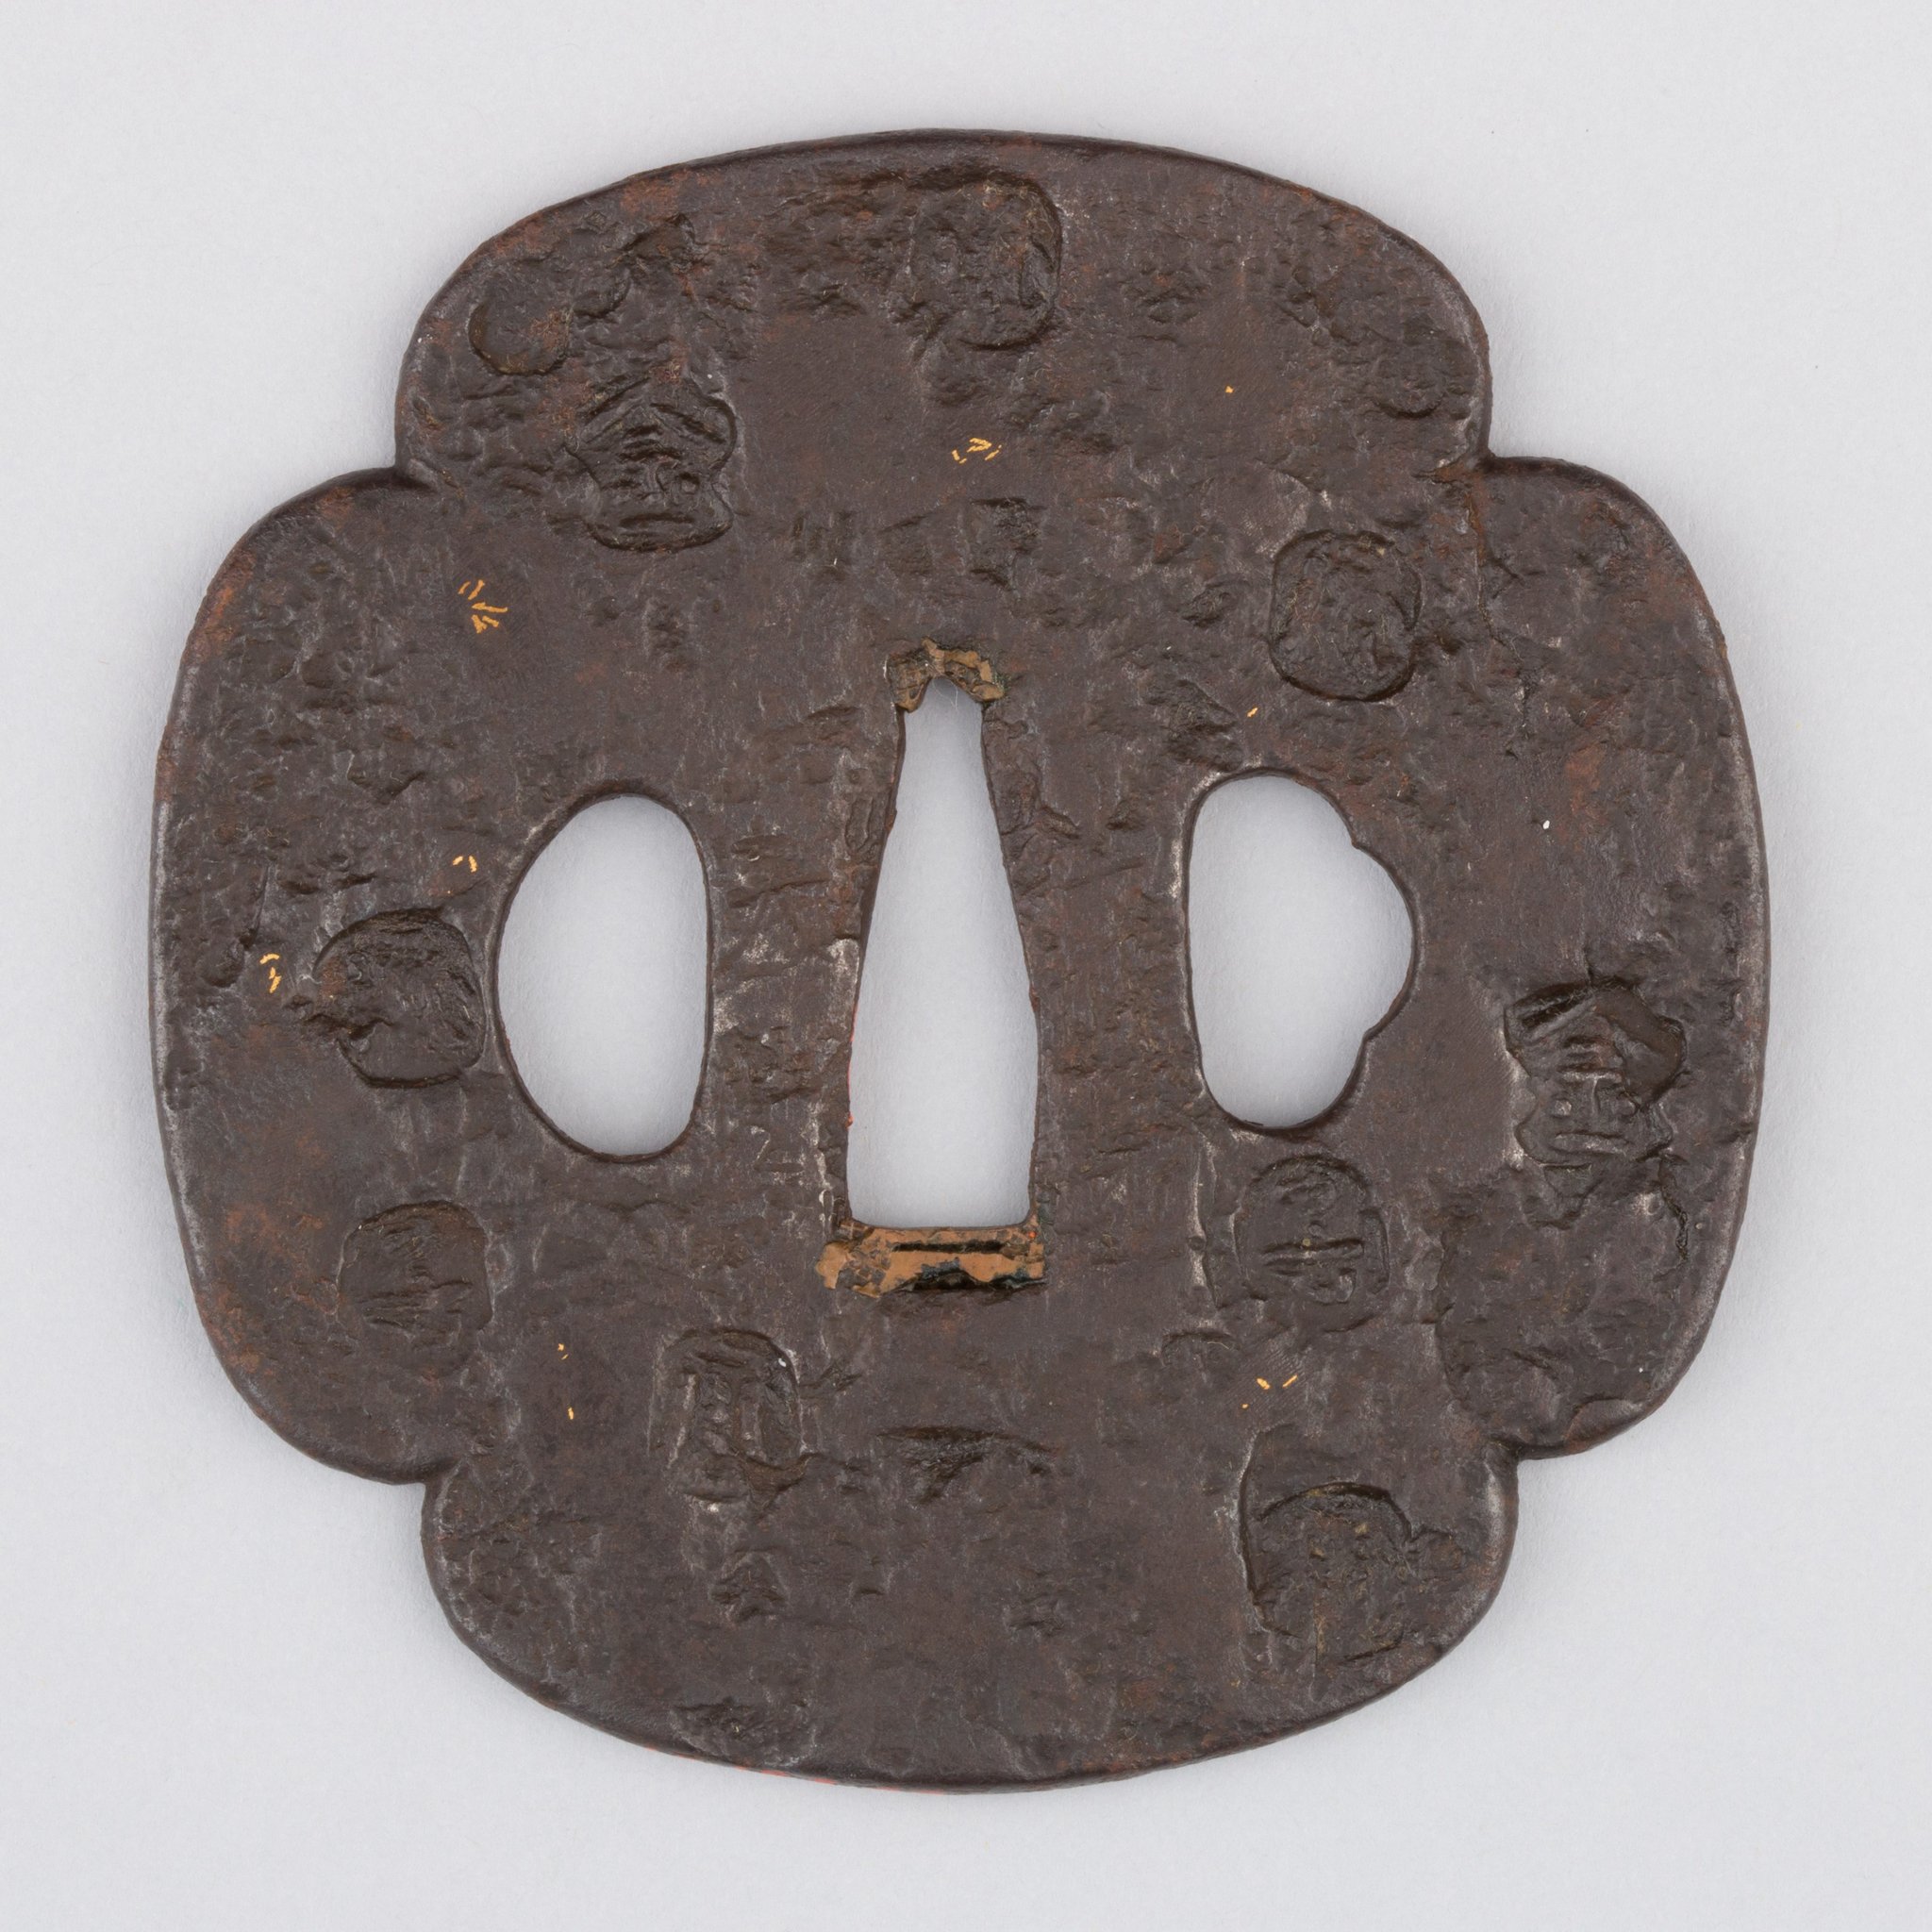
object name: sword guard tsuba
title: Sword Guard (Tsuba)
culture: japanese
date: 1615-1868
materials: copper, iron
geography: japan